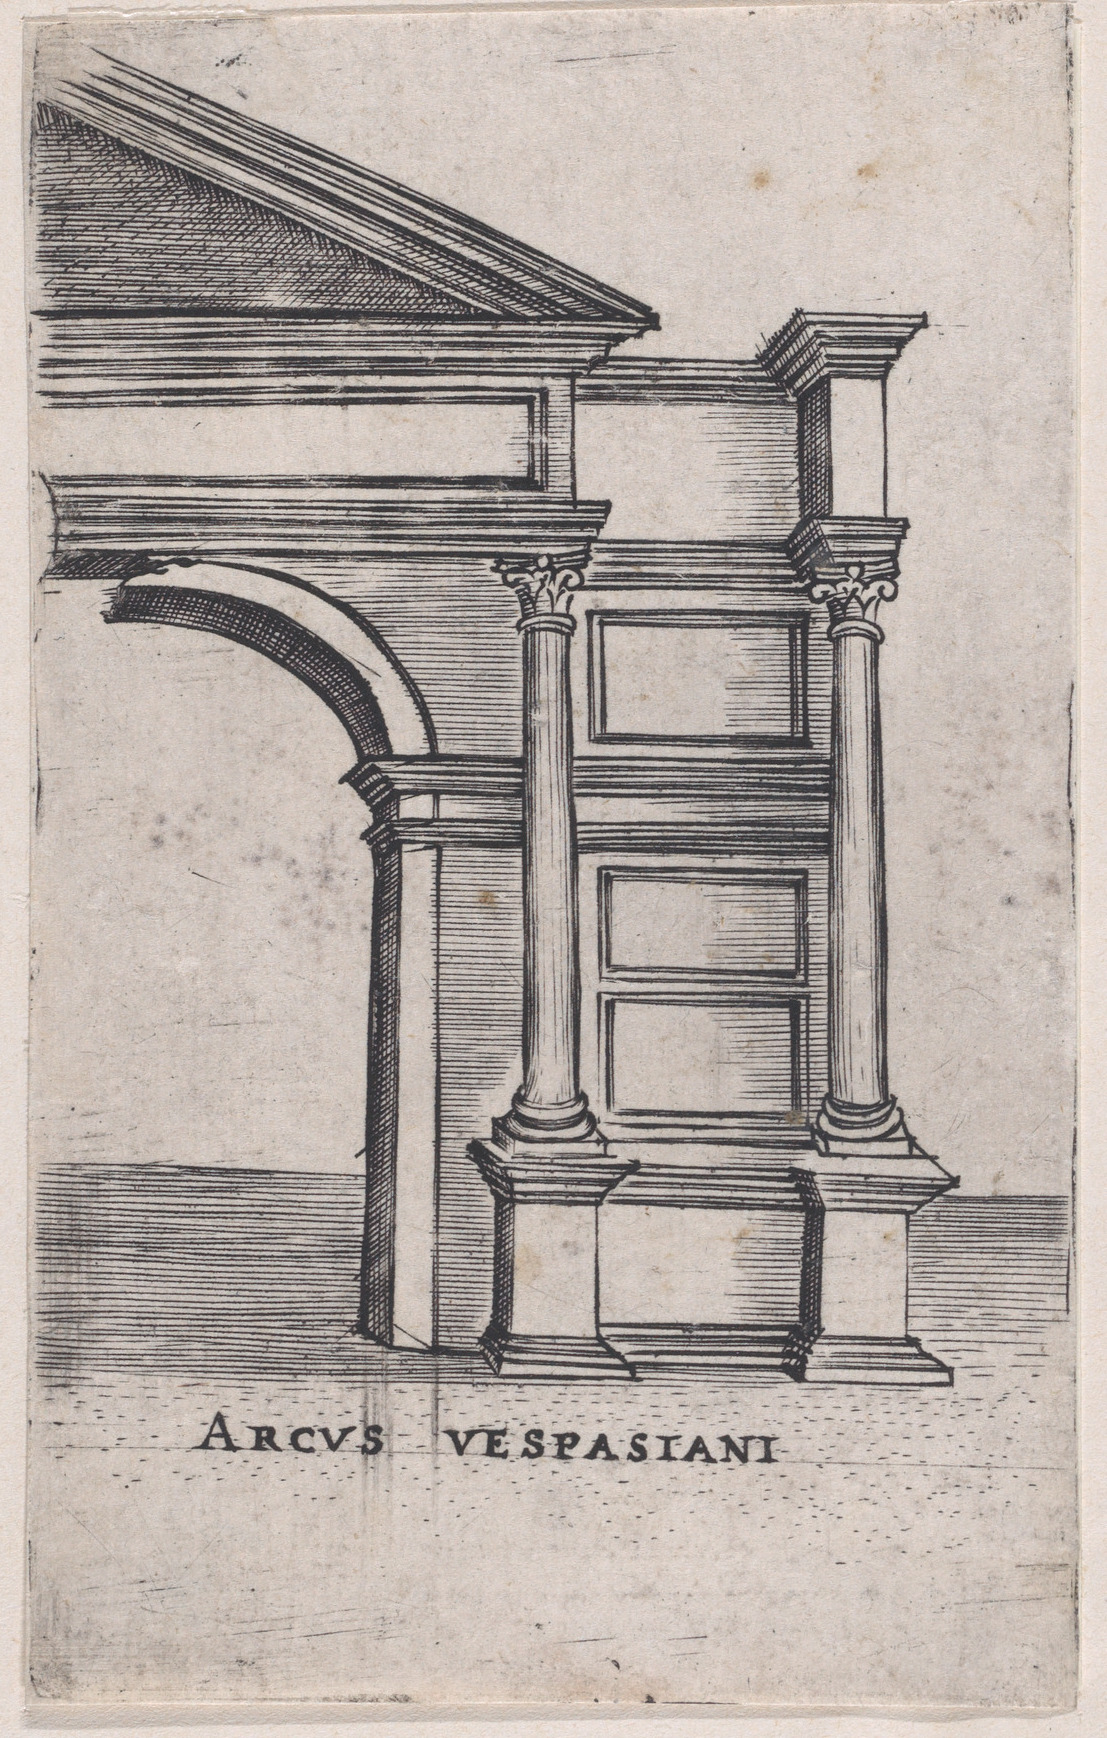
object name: print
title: Arcus Vespasiani, from "Views of Ancient Roman Temples and Arches"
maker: anonymous, italian, 16th century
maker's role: artist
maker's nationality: italian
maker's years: 1500-1600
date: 1535-1540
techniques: engraving